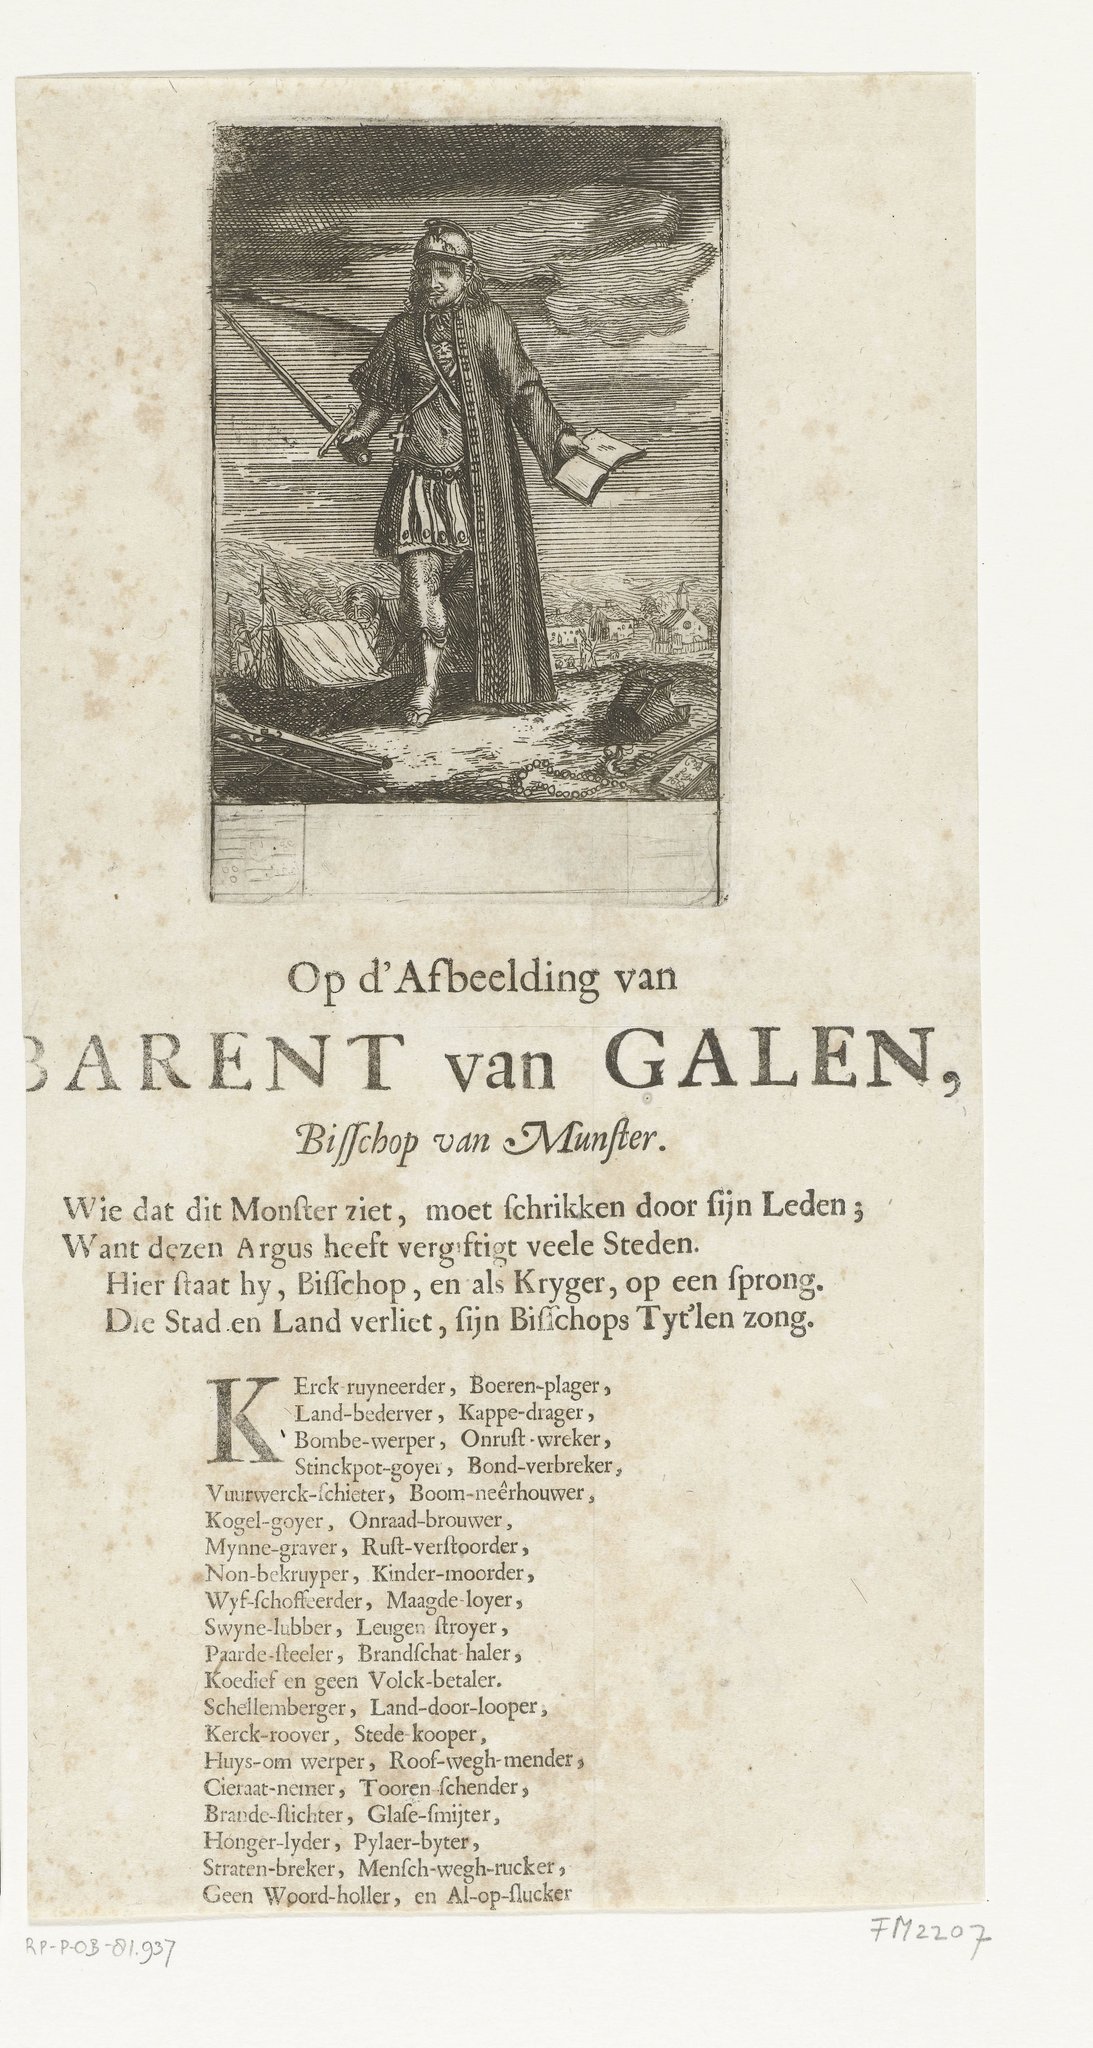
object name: print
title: Spotprent op de bisschop van Munster, 1665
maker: Anonymous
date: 1665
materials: paper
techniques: etching, letterpress printing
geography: northern netherlands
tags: bisschop, christoph bernhard von galen, tweede engelse oorlog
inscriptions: date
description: Spotprent op Christoph Bernard von Galen, de bisschop van Munster, bij het uitbreken van de Tweede Engelse Oorlog, 1665. De bisschop half gekleed als soldaat en half als bisschop staande met zwaard en boek in de handen. Onder de plaat op het blad gedrukt twee spotverzen op de bisschop.